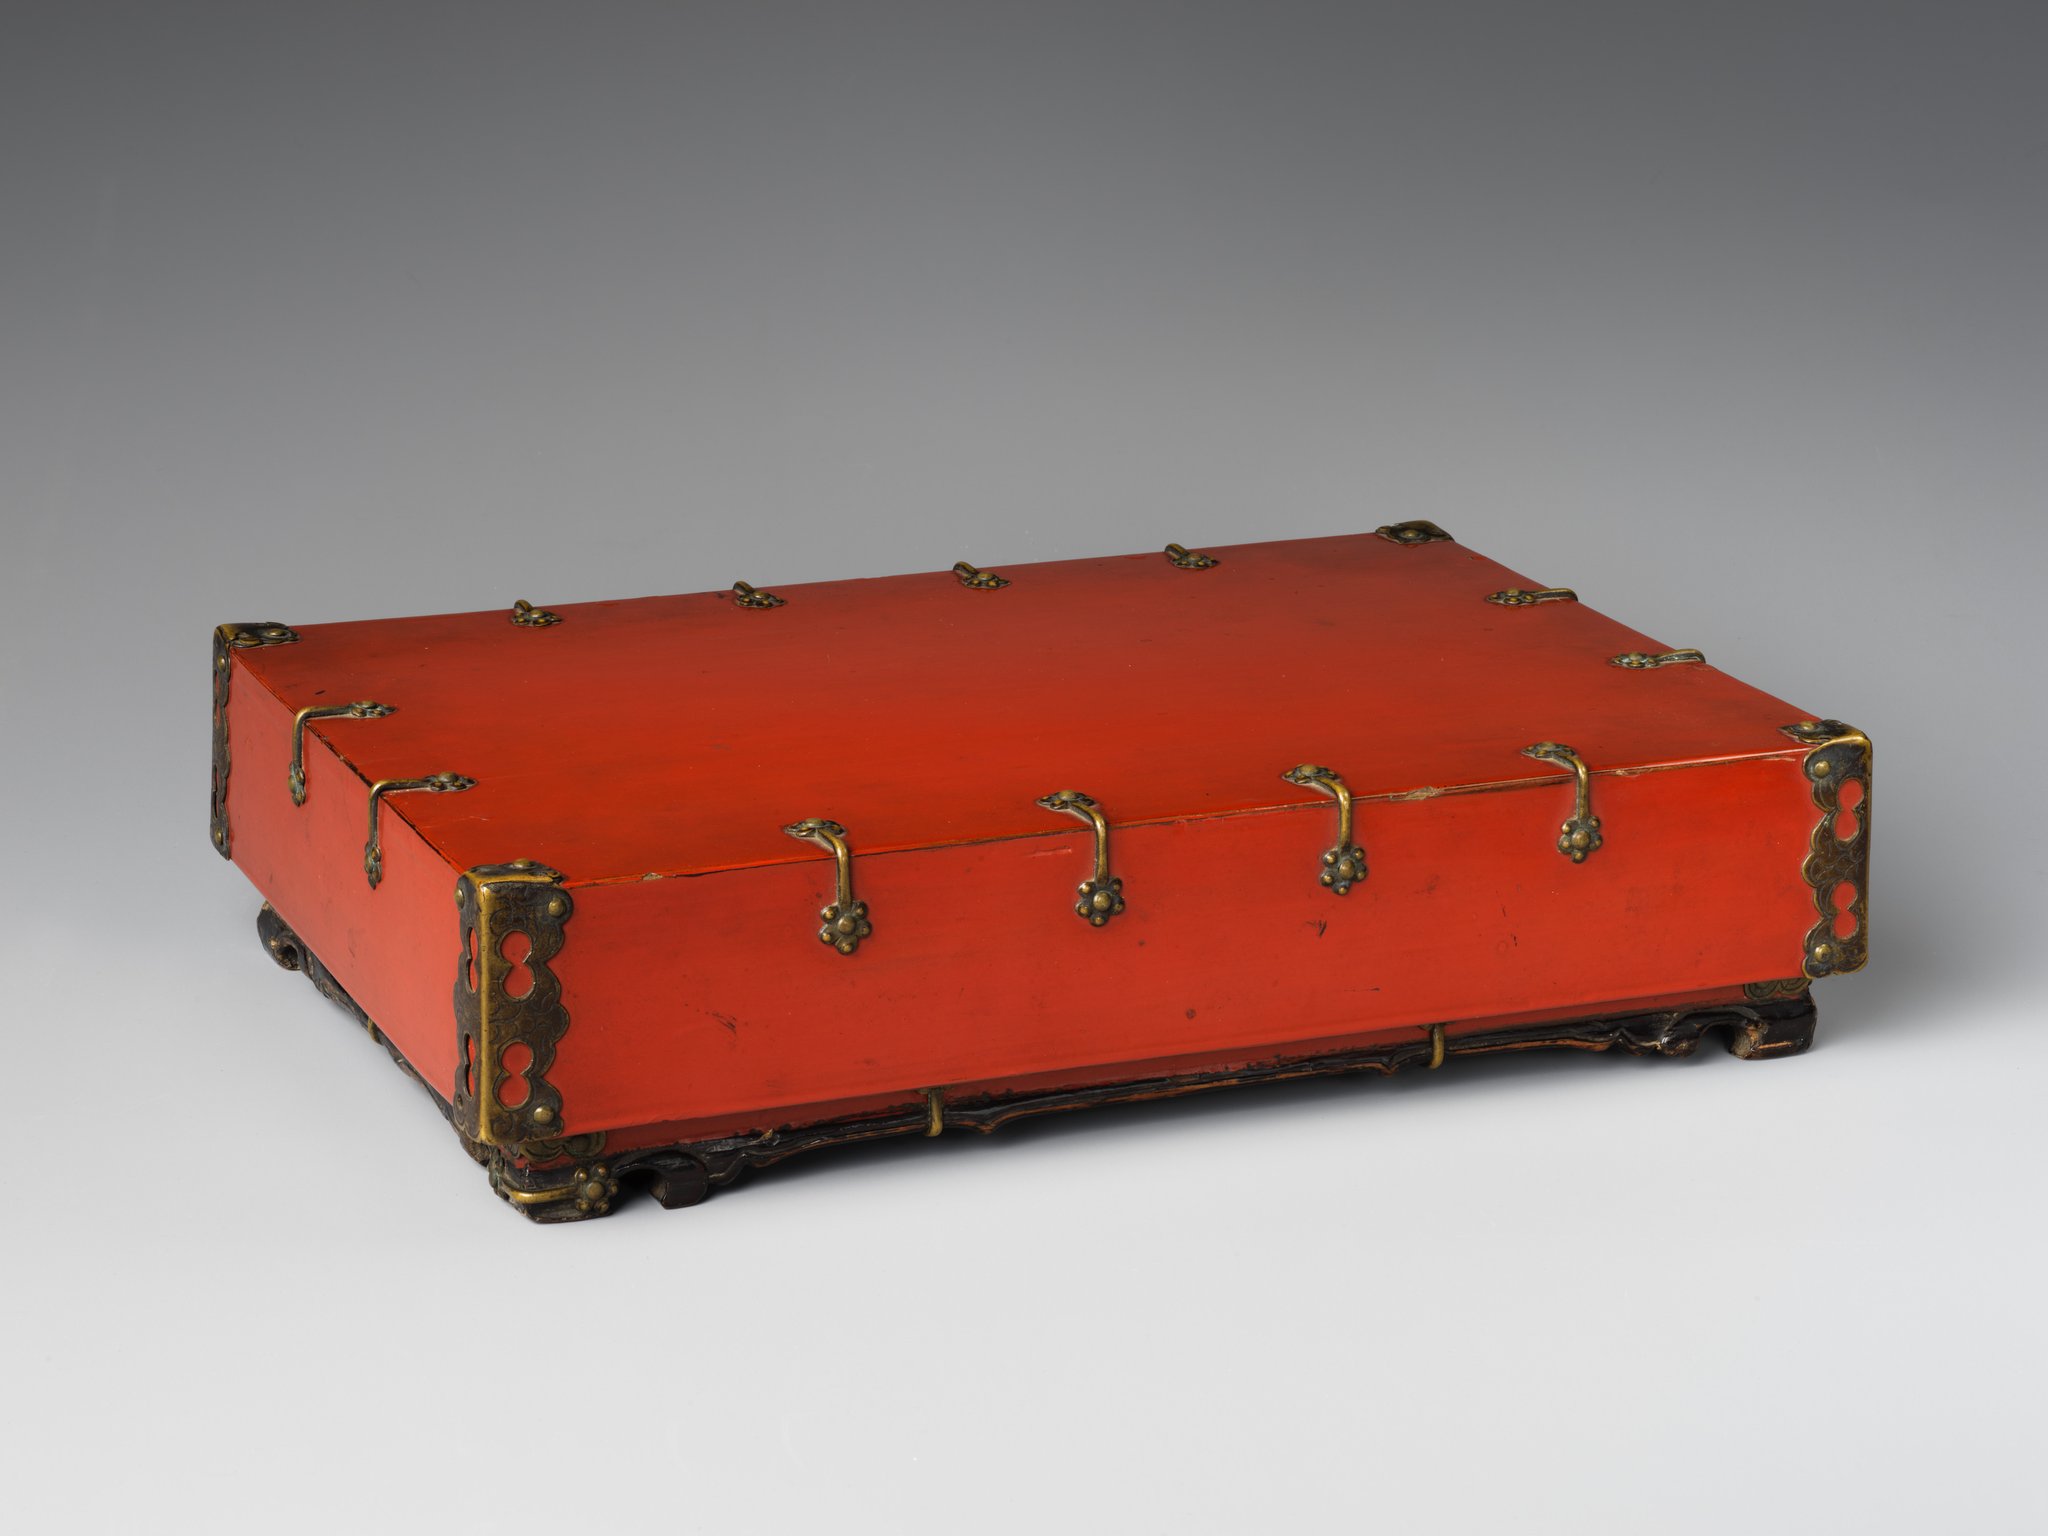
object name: box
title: Red lacquer box for an inkstone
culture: korean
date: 1801-1900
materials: brass, lacquer